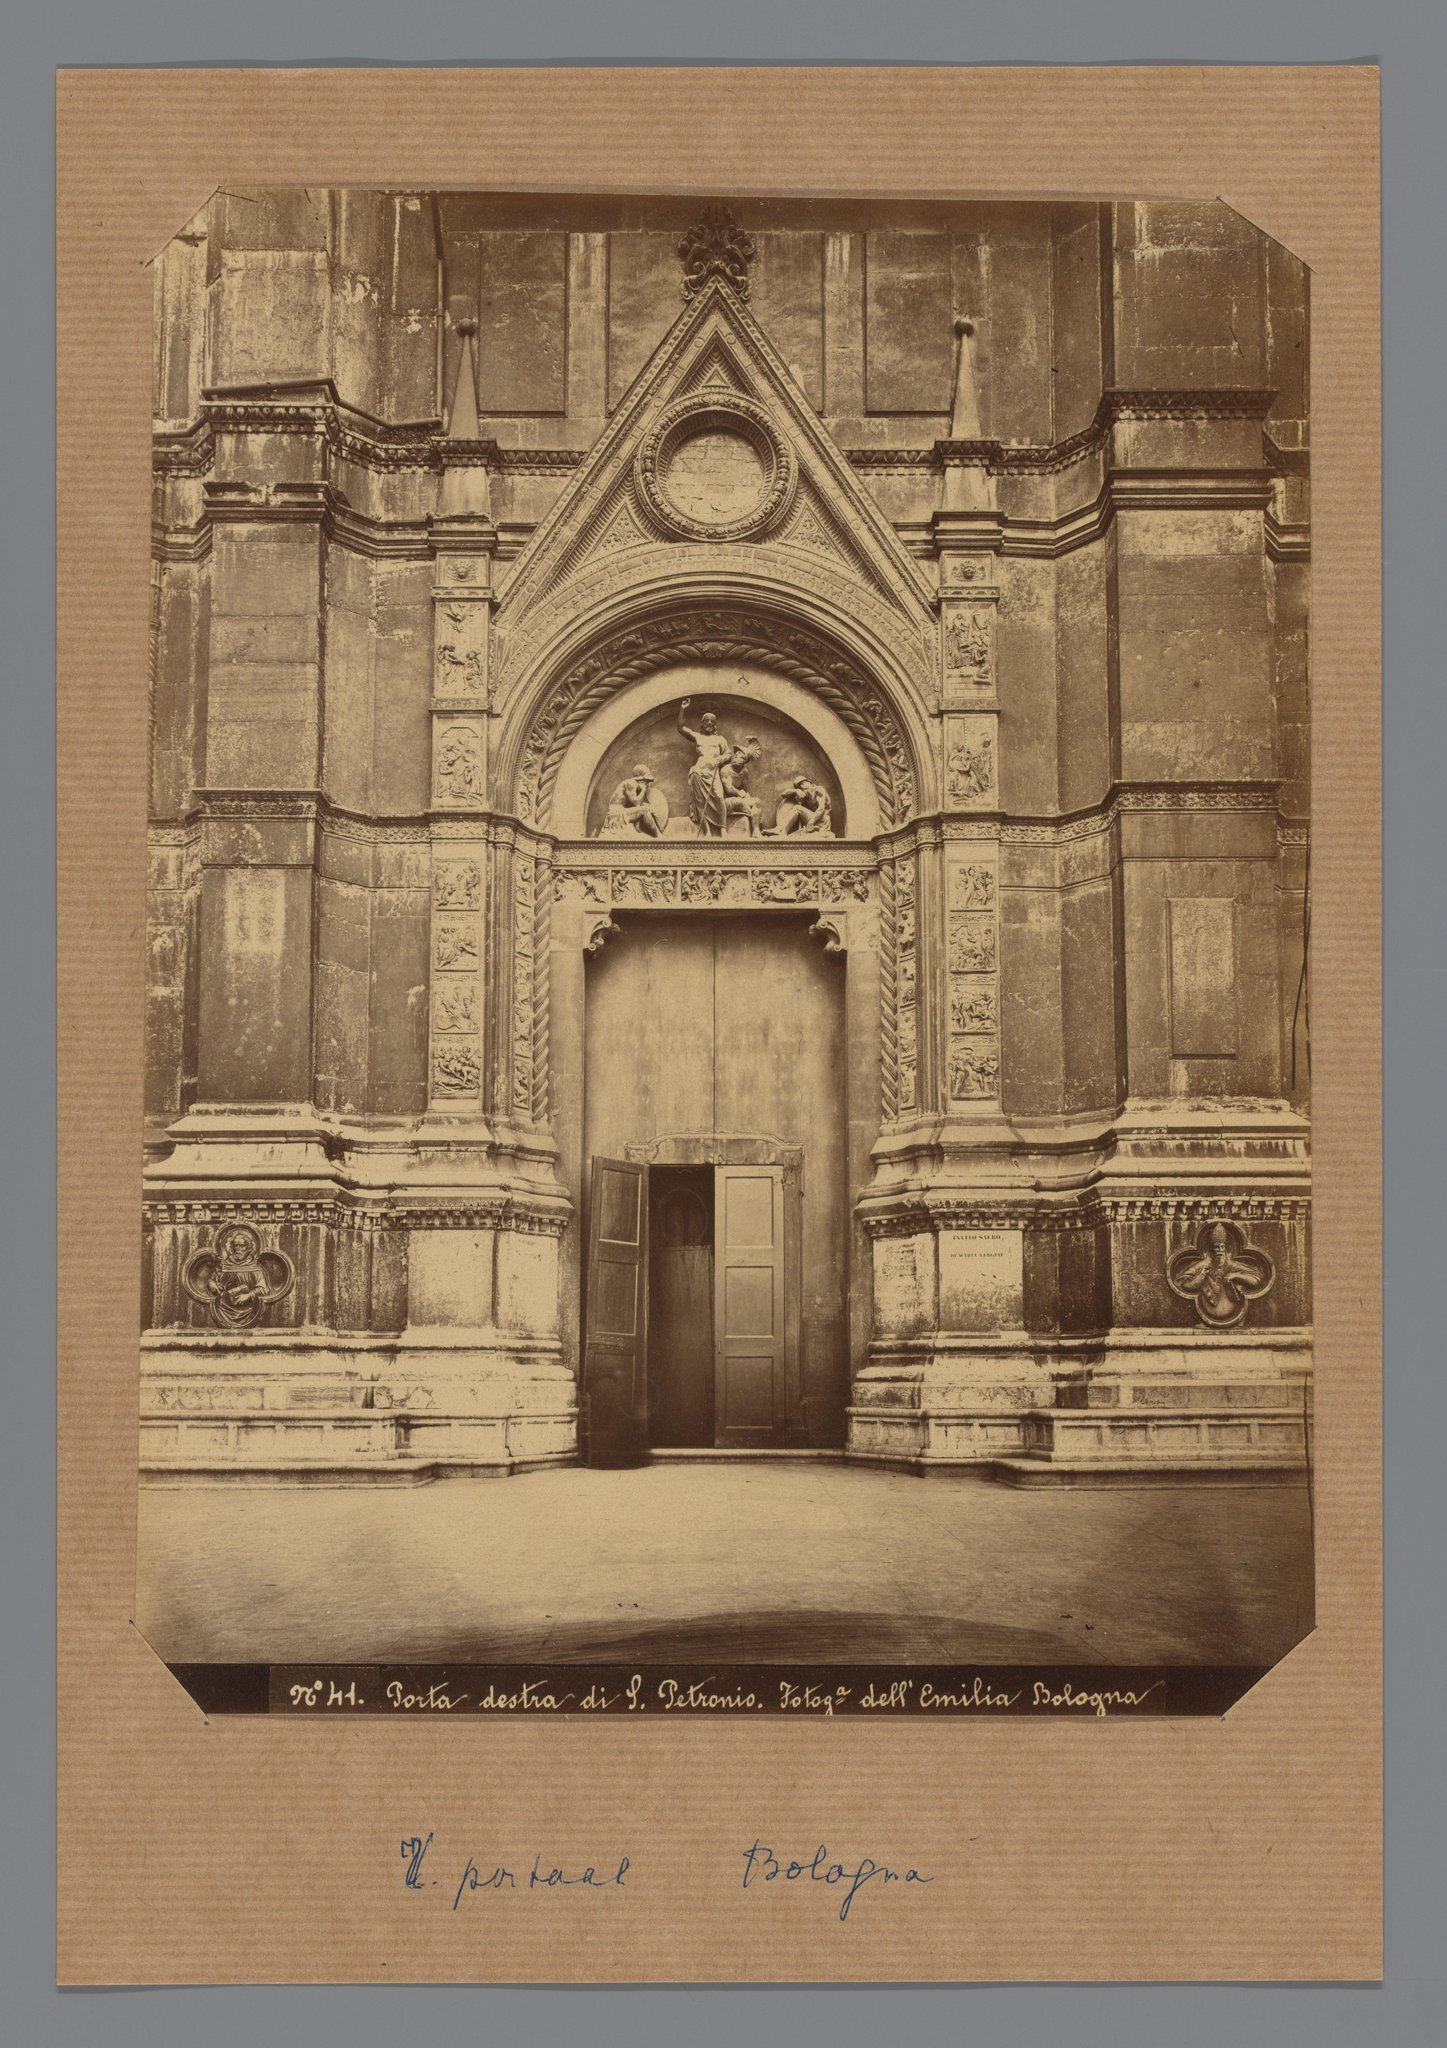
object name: photograph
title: Italië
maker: Anonymous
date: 1880-1910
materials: photographic support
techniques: albumen print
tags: italy